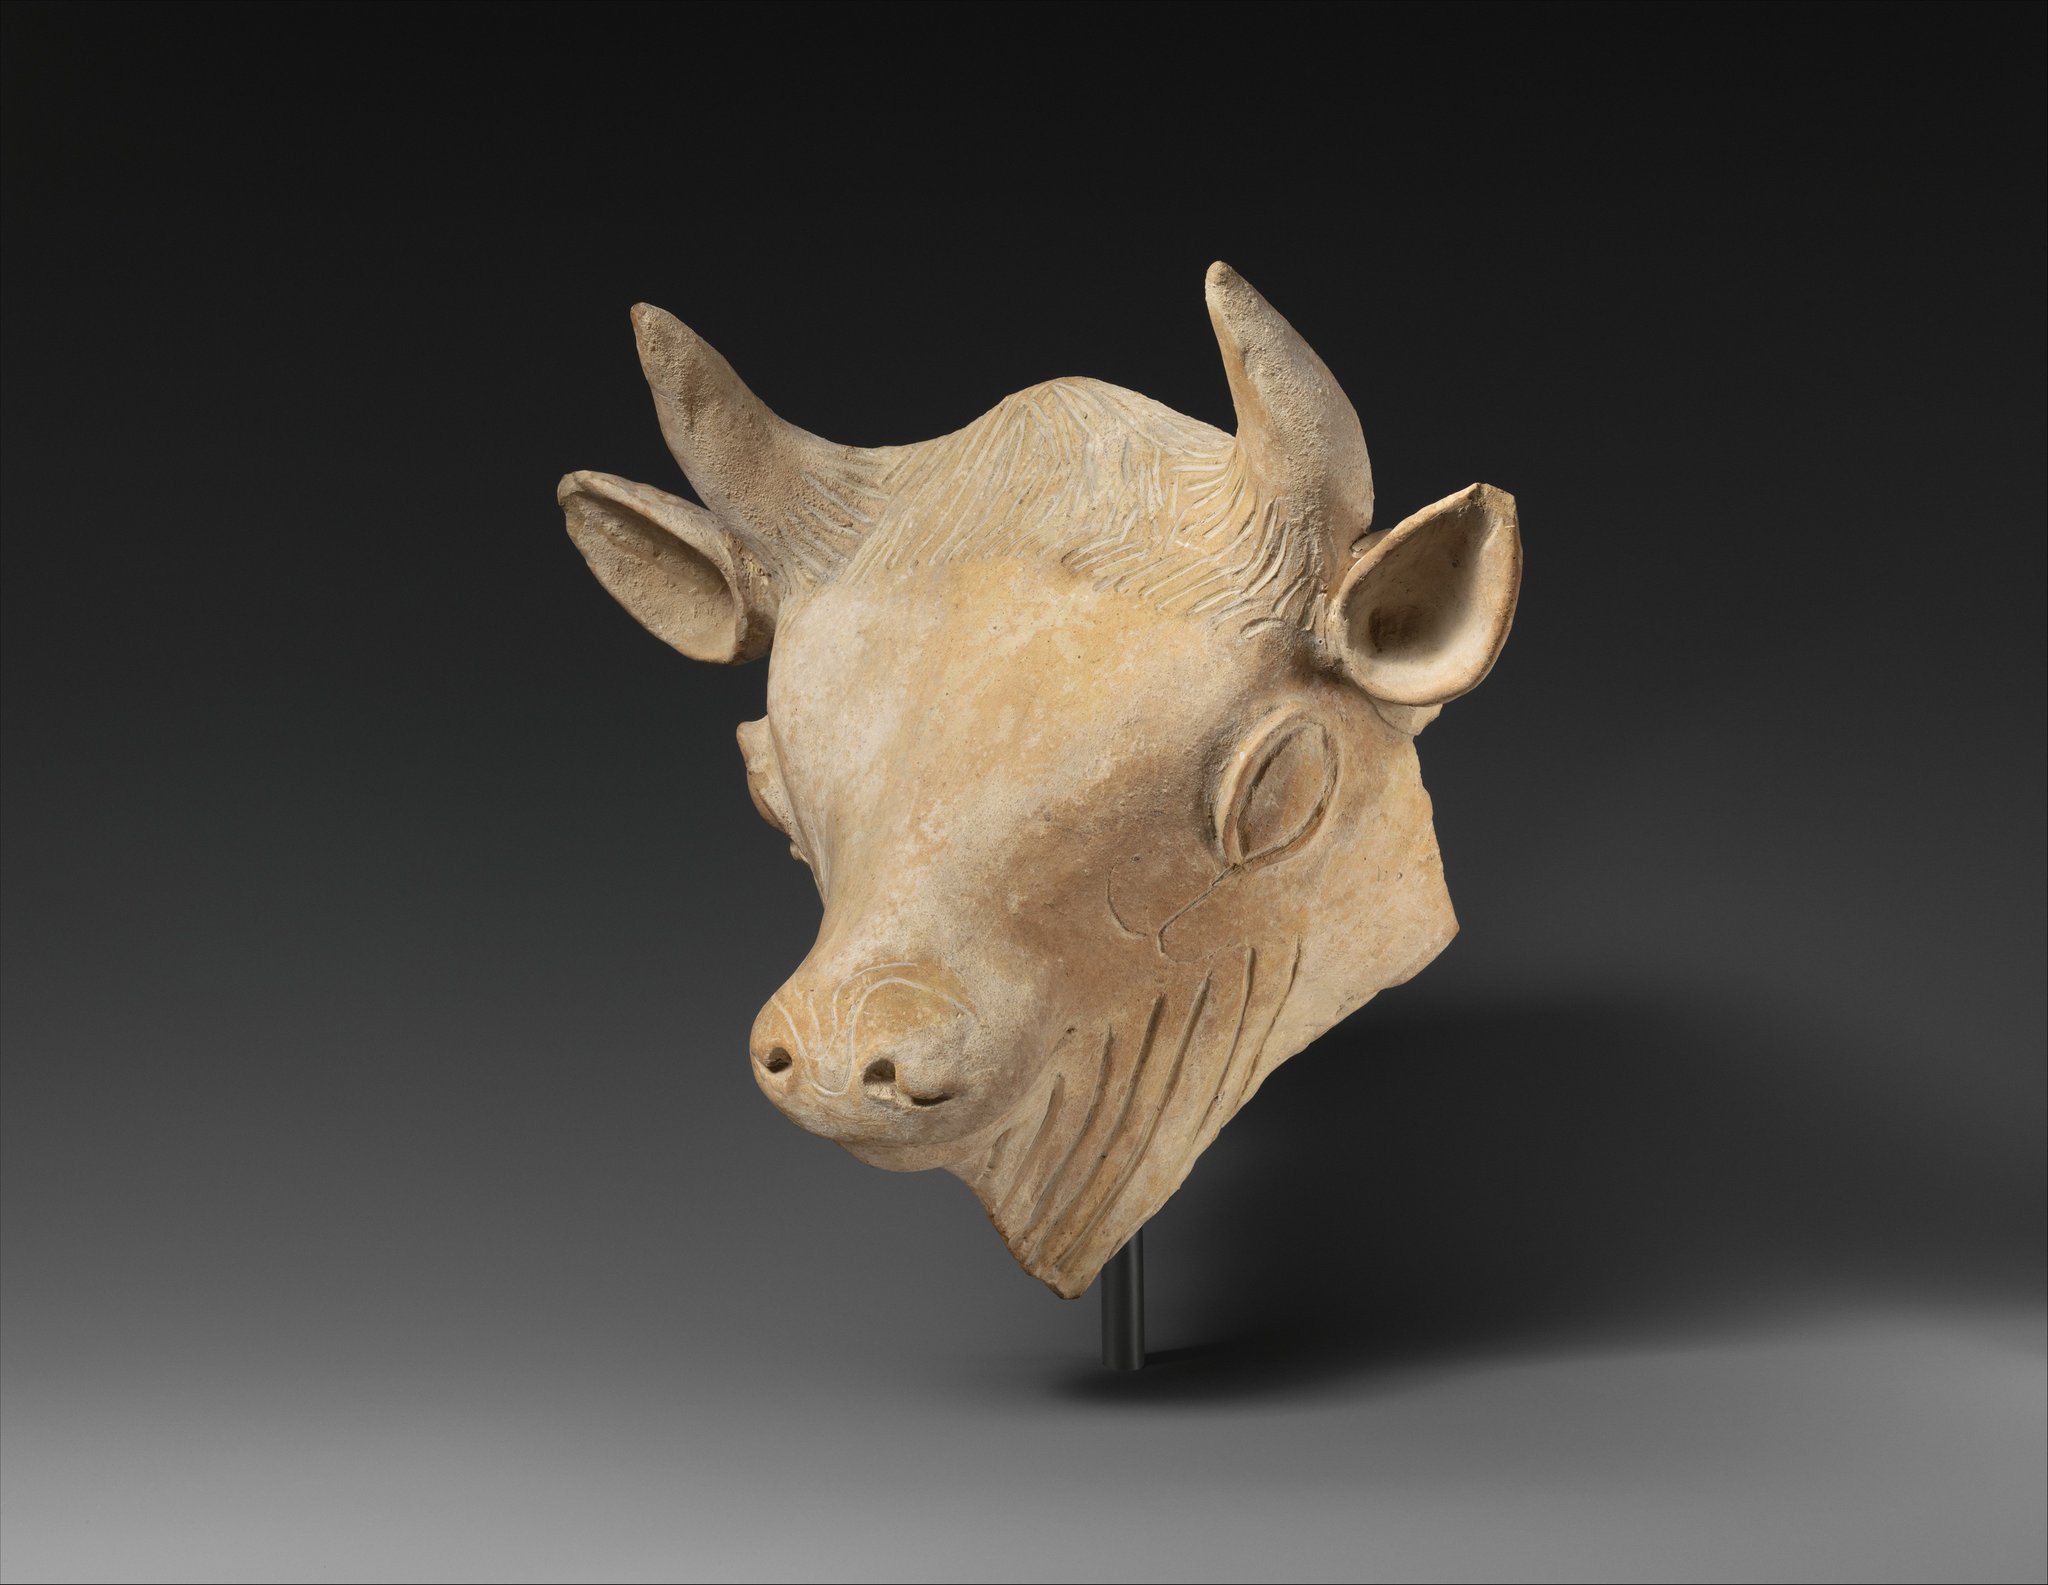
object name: head of a bull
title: Terracotta head of a bull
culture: cypriot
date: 534-468 BCE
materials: terracotta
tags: bulls